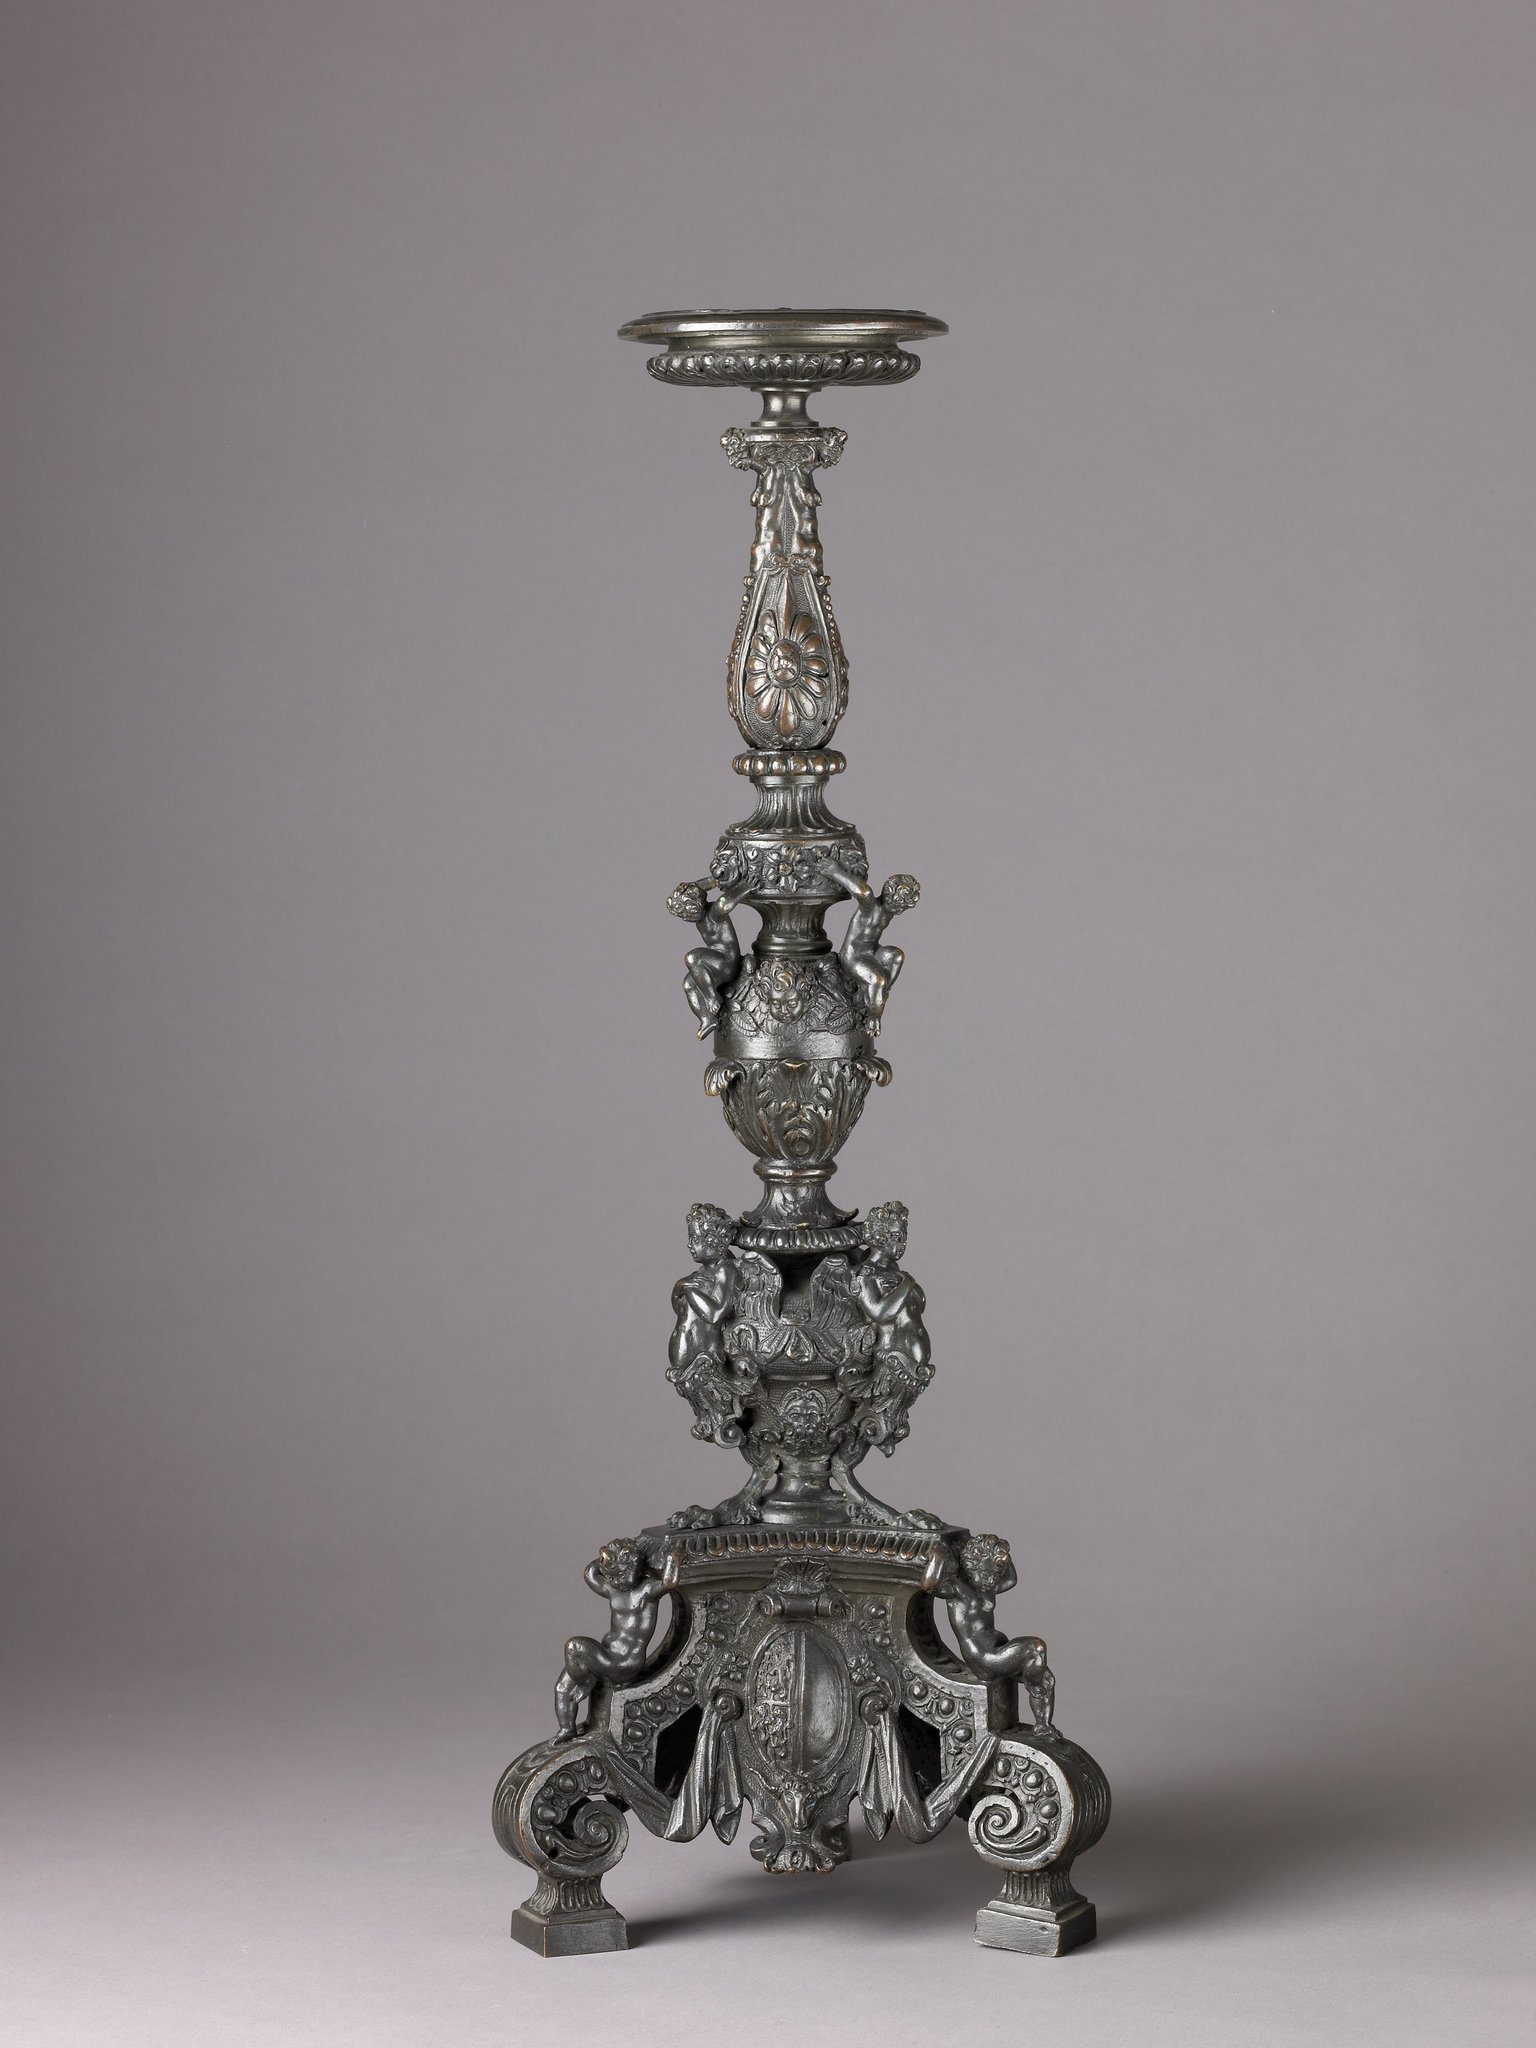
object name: candelabrum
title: Candelabra Supported by Putti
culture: italian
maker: niccolò roccatagliata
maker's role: artist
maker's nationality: italian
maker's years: 1593-1636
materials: copper alloy, lacquer, patina, wax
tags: putti